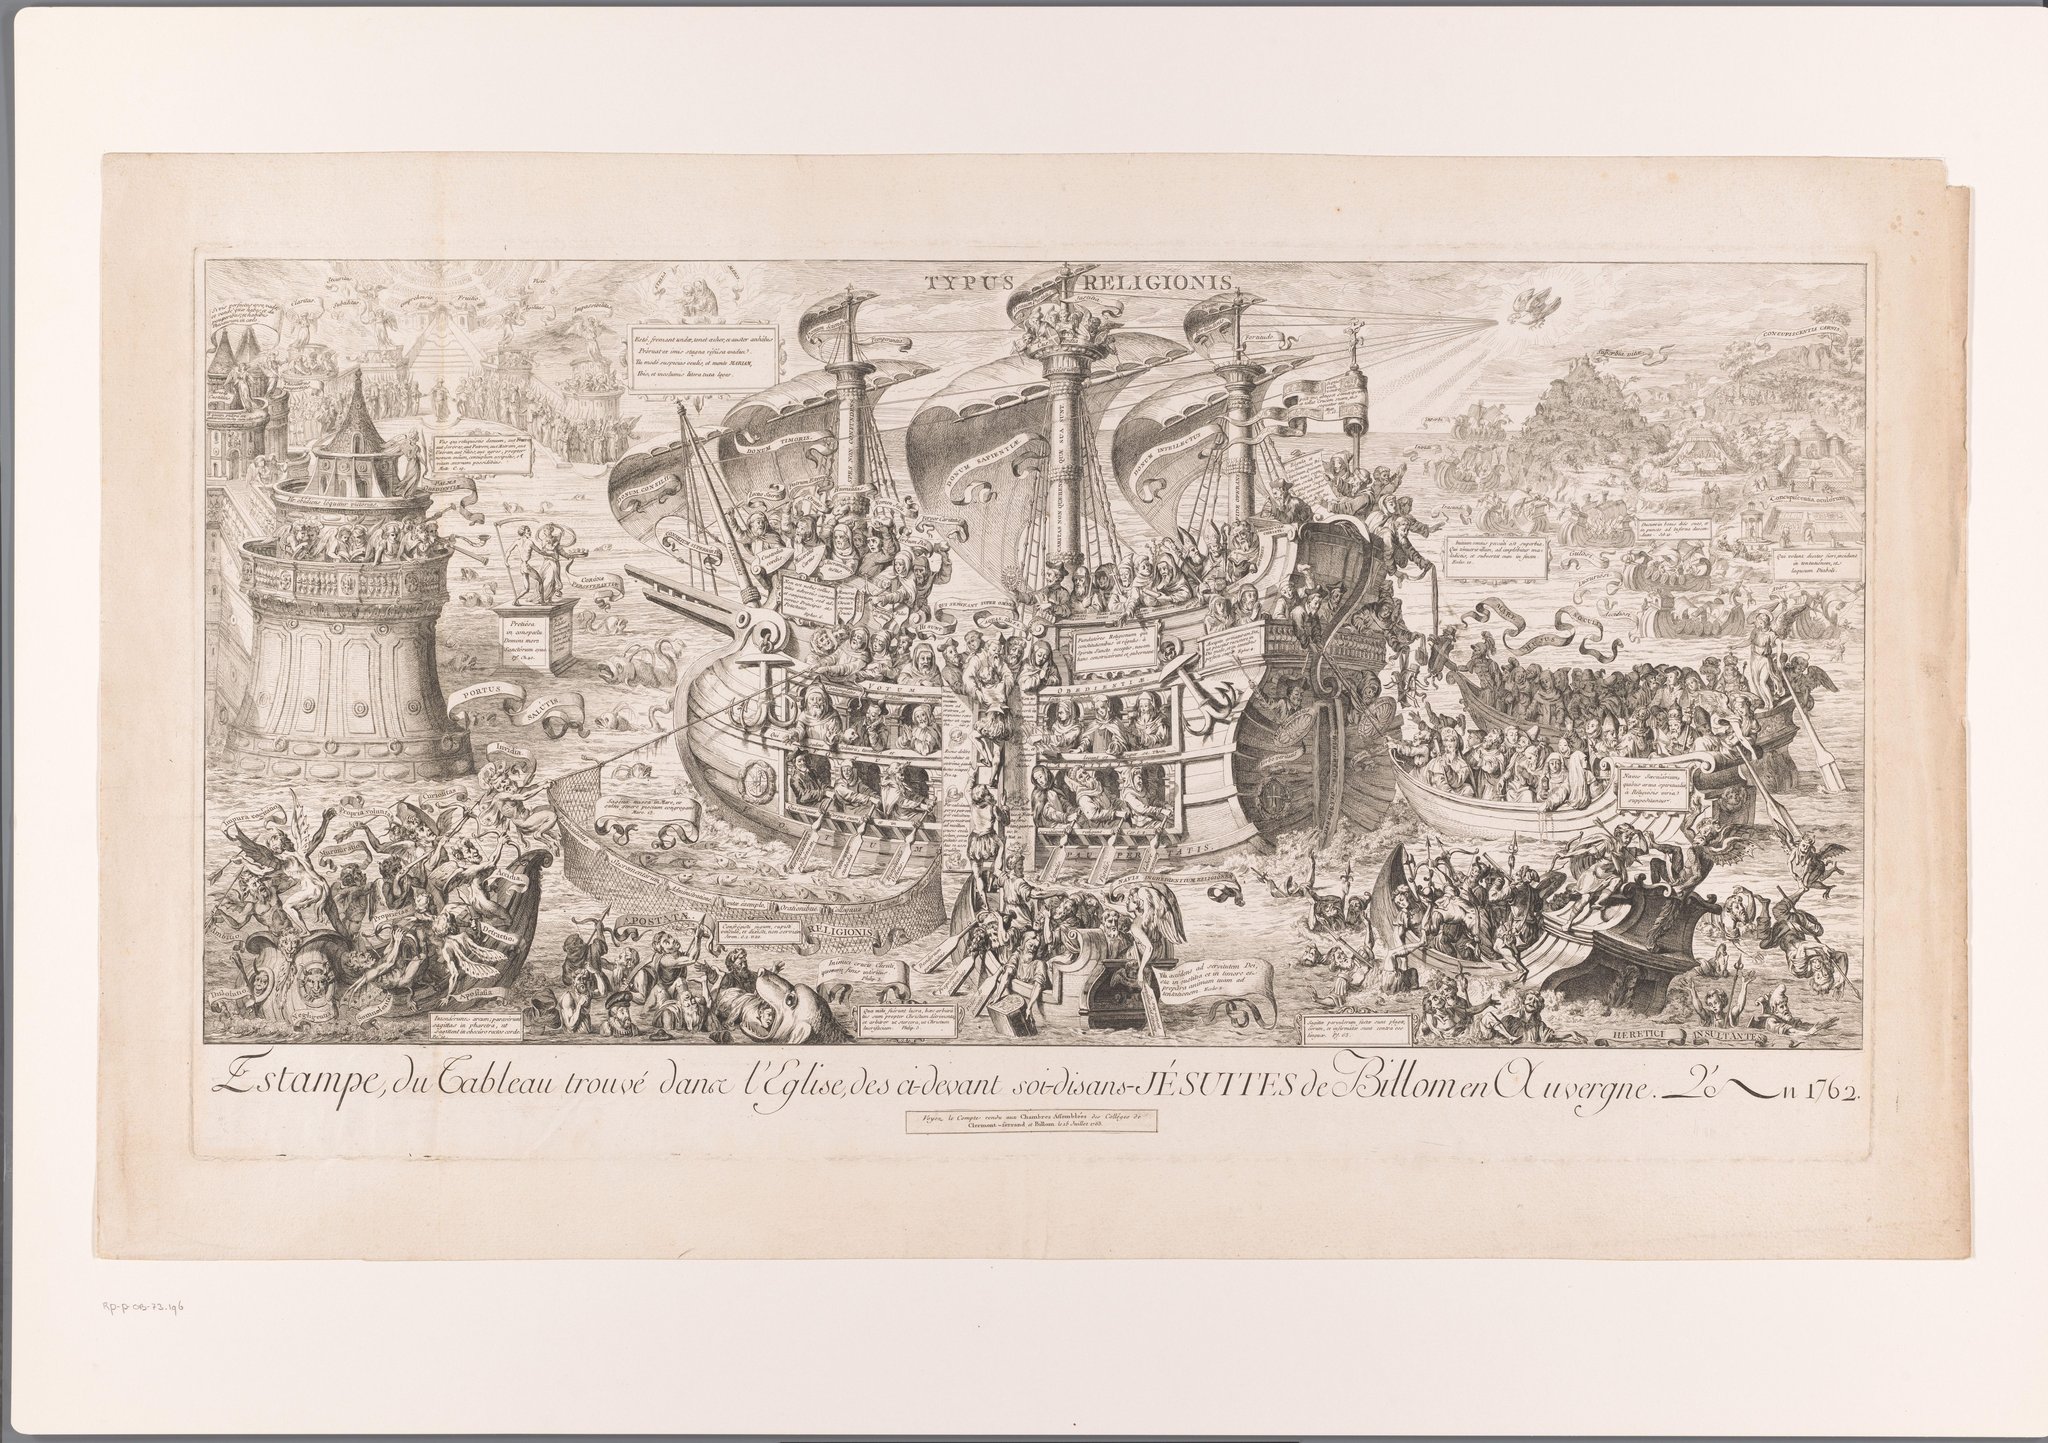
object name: print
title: Typus Religionis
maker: Anonymous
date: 1763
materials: paper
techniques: etching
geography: france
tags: ships (in general)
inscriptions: collector's mark: Lugt 2228